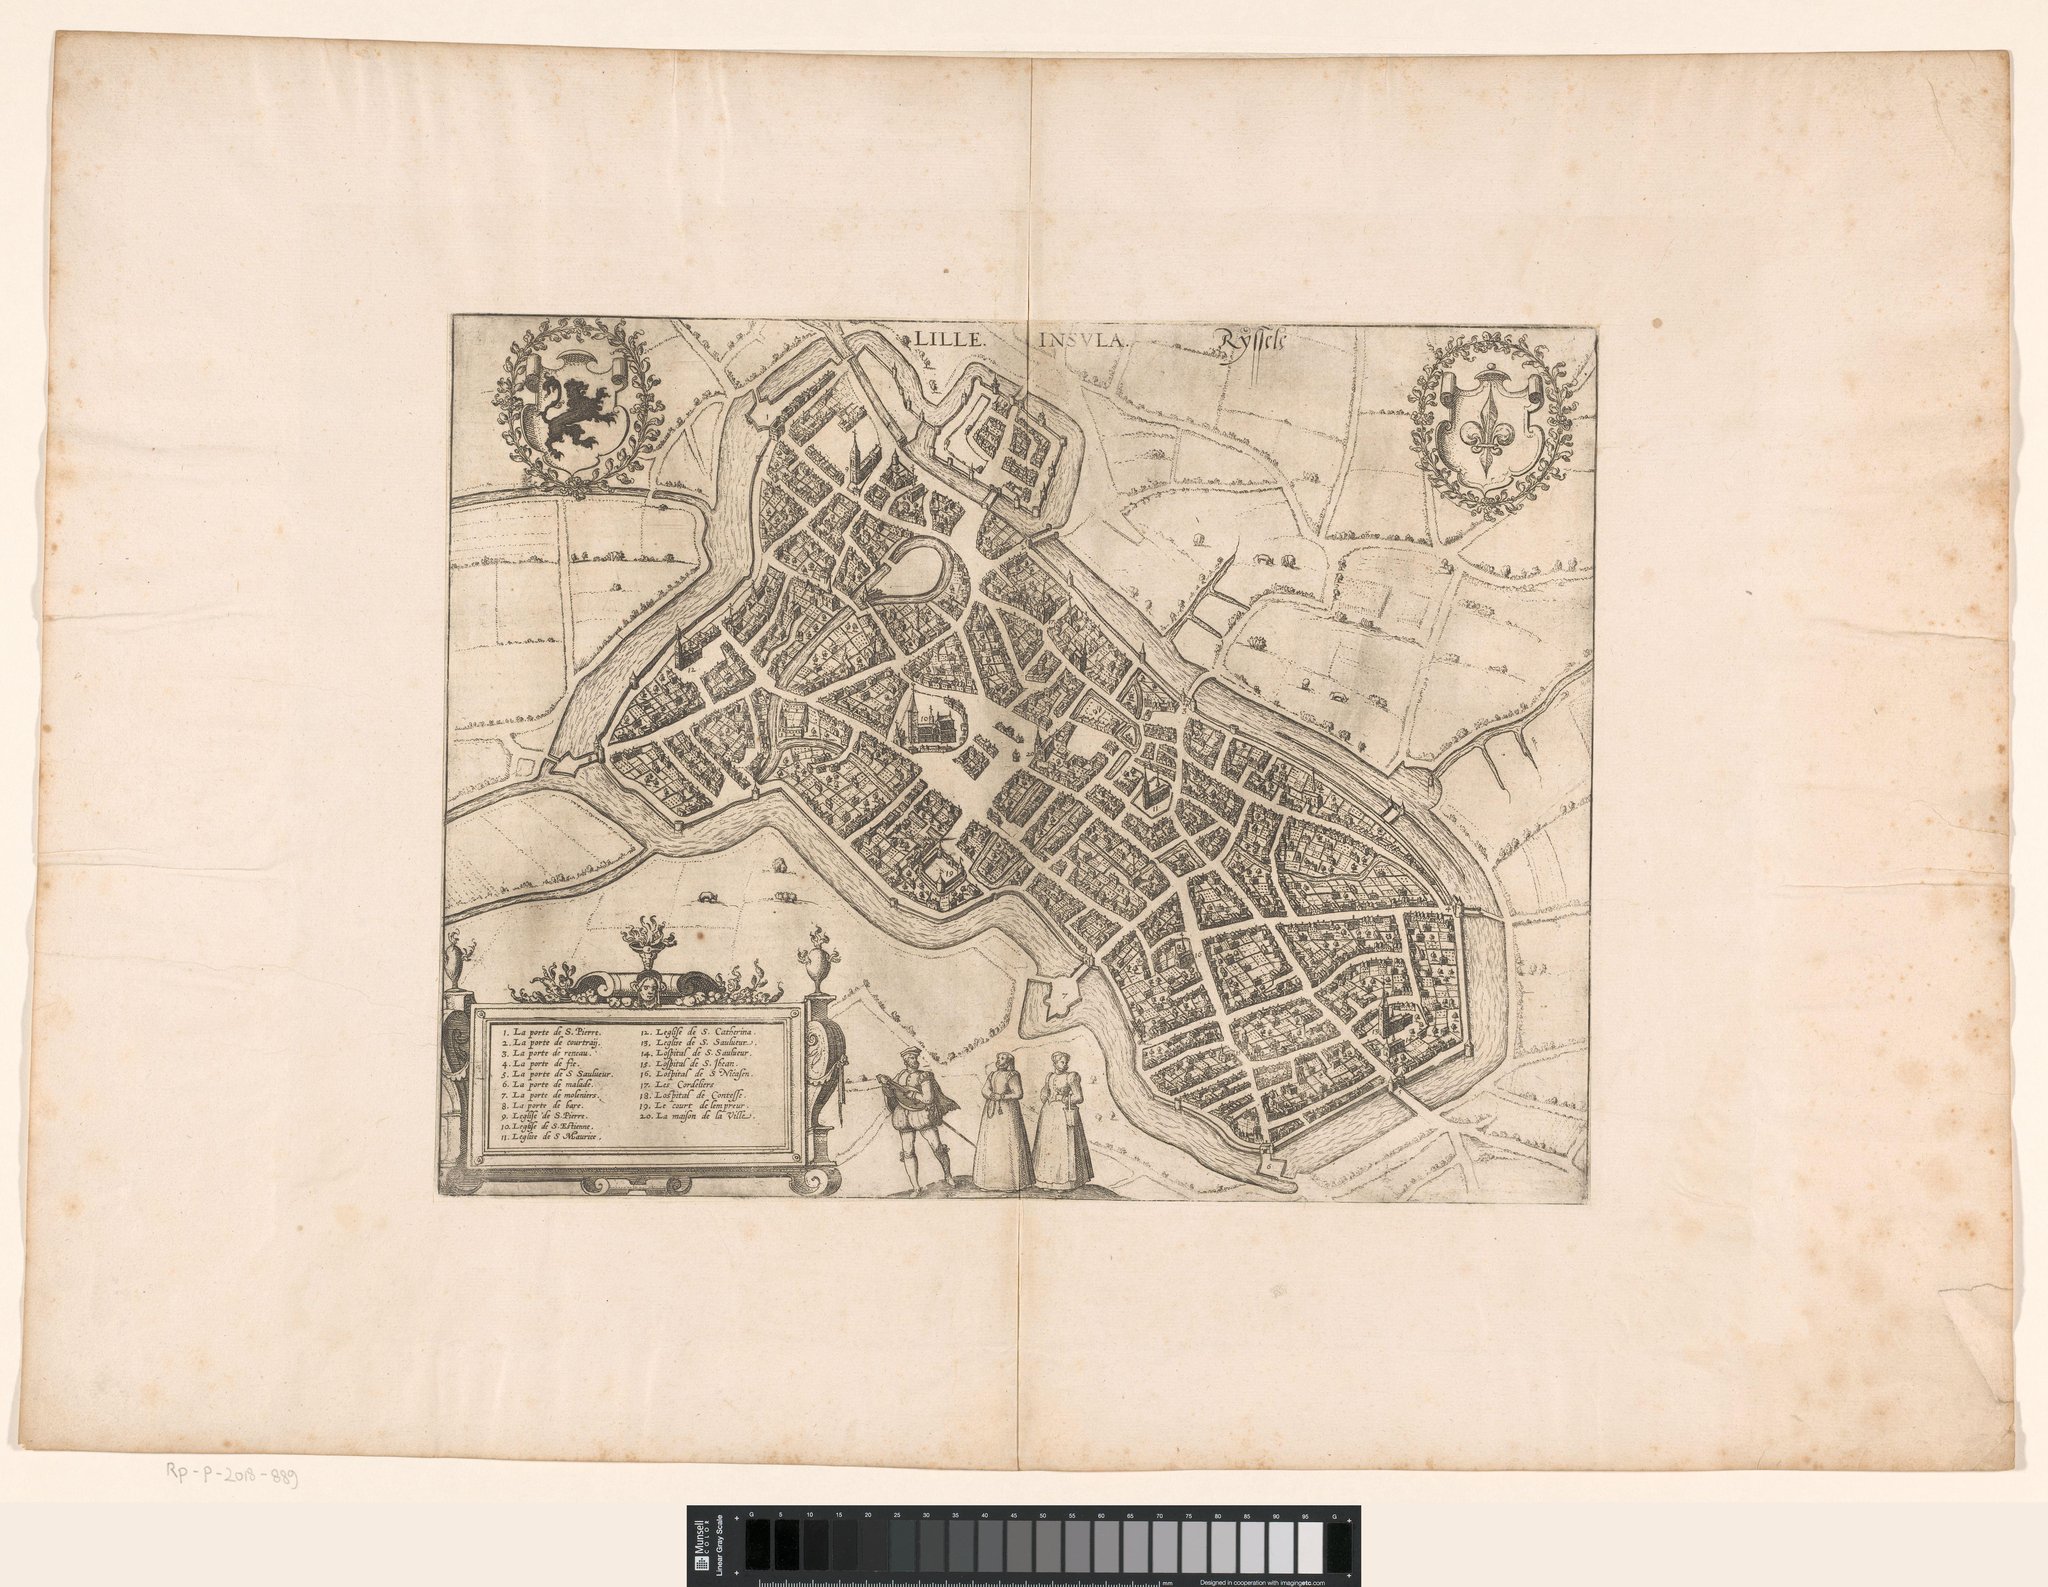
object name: print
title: Lille. Insula. Rÿssele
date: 1581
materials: paper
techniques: engraving, etching, letterpress printing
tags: coat of arms (as symbol of the state, etc.) (+ city; municipal), maps of cities, coat of arms (as symbol of the state, etc.) (+ province; provincial)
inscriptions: collector's mark: Lugt 2228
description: Plattegrond van Lille met gebouwen in vogelvluchtperspectief. Met Latijnse tekst op verso.